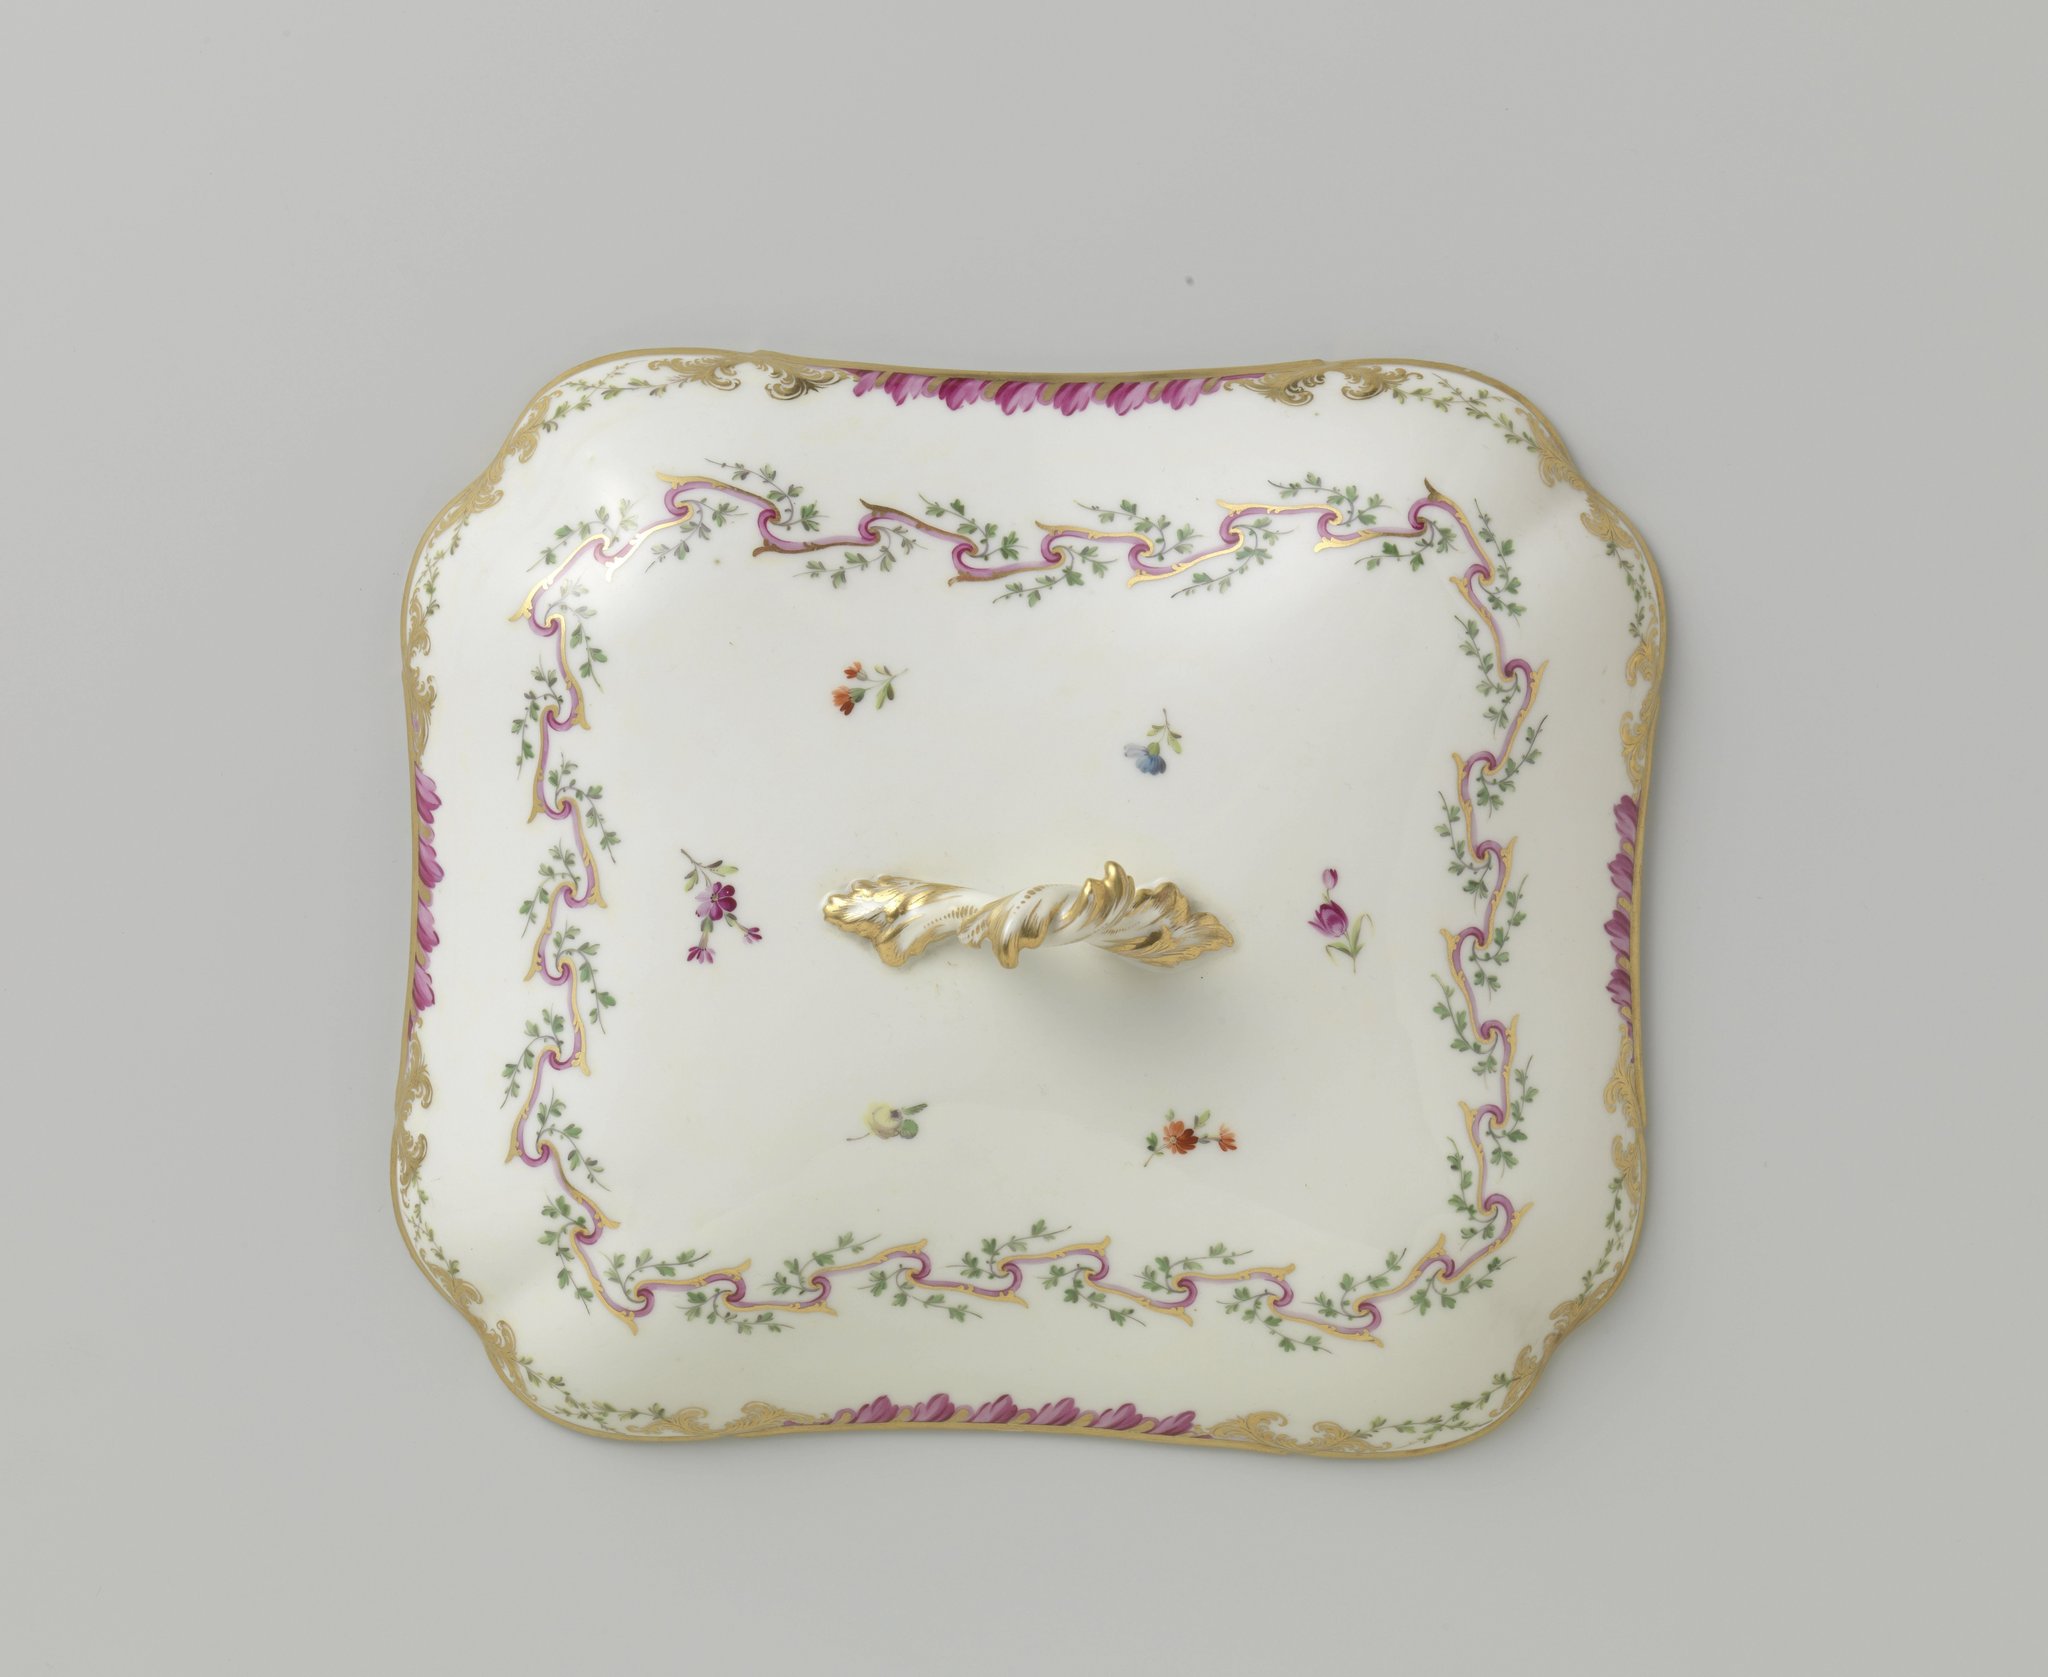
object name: vessel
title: Deksel, langwerpig, met knop, behorend bij een servies met geslingerd lintmotief met bladertakken, bloemboeketten en gestrooide bloemtakken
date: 1780-1820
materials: porcelain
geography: loosdrecht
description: Deksel, langwerpig, met knop, behorend bij een servies van porselein met geslingerd motief in paars en goud met groene bladertakken, bloemboeketten en gestrooide bloemtakken. Randen lichtgegolfd met decoratie in goud met paars bladmotief waartussen groen gekruist bladmotief. Gemerkt: M.O.L. en AMSTEL.